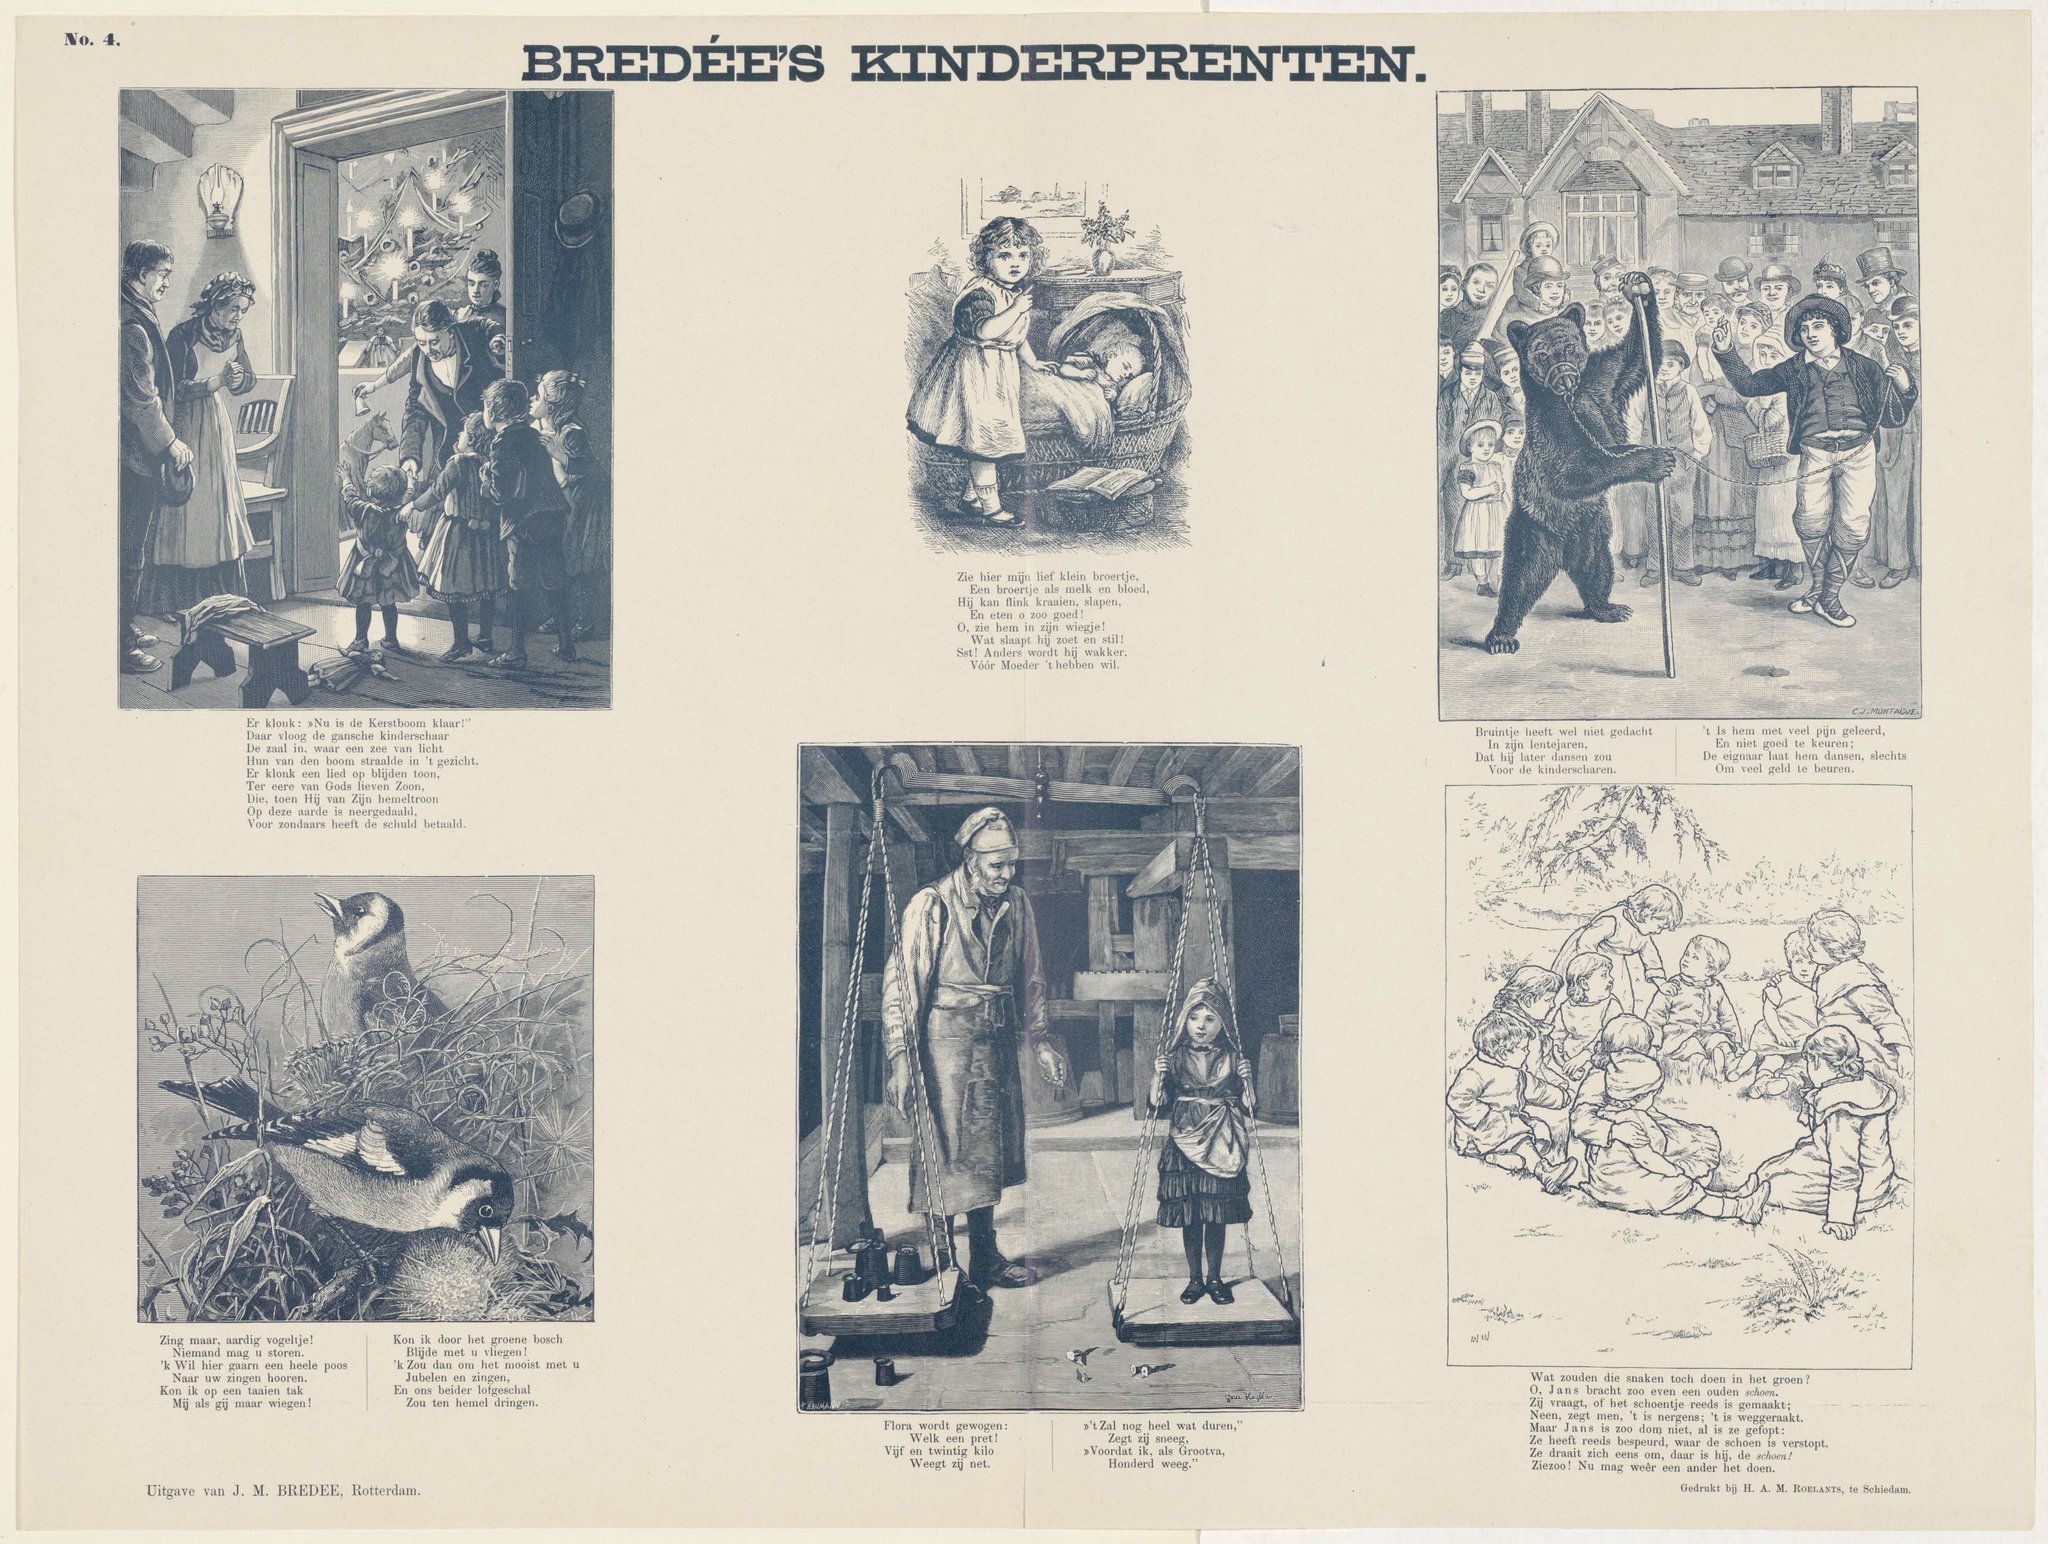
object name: print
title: Verschillende voorstellingen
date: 1894-1918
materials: paper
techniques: letterpress printing, line block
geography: rotterdam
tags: weighing on witch-scales, beasts of prey, predatory animals: bear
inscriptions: collector's mark: Lugt 2760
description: Blad met 6 voorstellingen van verschillende aard, zoals voorstellingen van Bruintje de dansende beer en van Flora die gewogen wordt op een grote weegschaal. Onder elke afbeelding een acht- of negenregelig vers. Genummerd linksboven: No. 4.